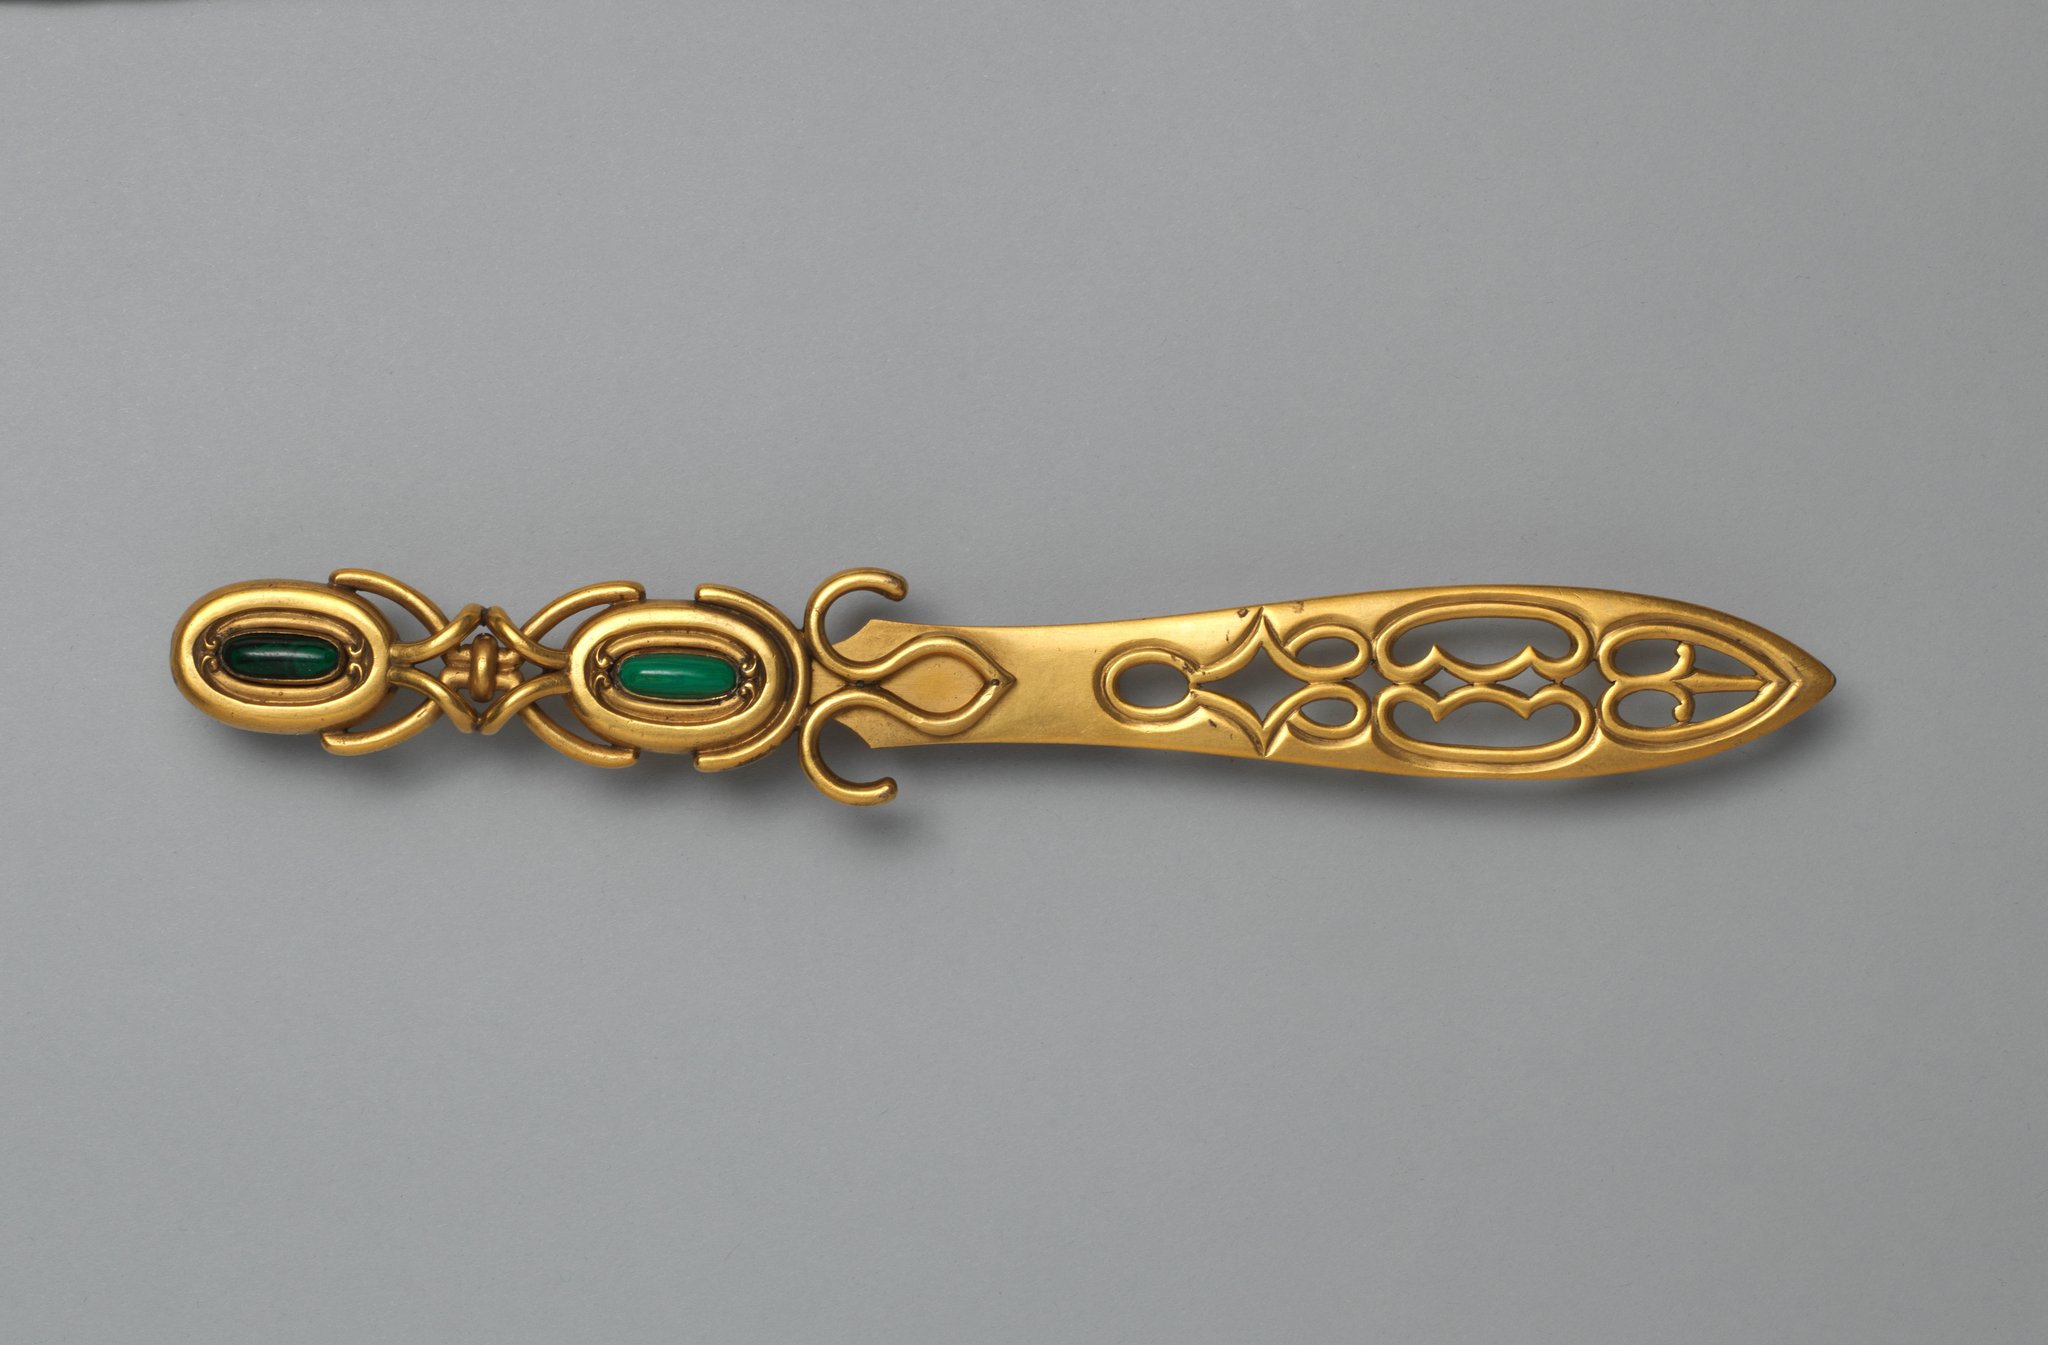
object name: paper cutter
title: Paper cutter (part of a set)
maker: asprey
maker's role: purveyor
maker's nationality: british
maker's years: 1781-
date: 1851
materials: gilt bronze